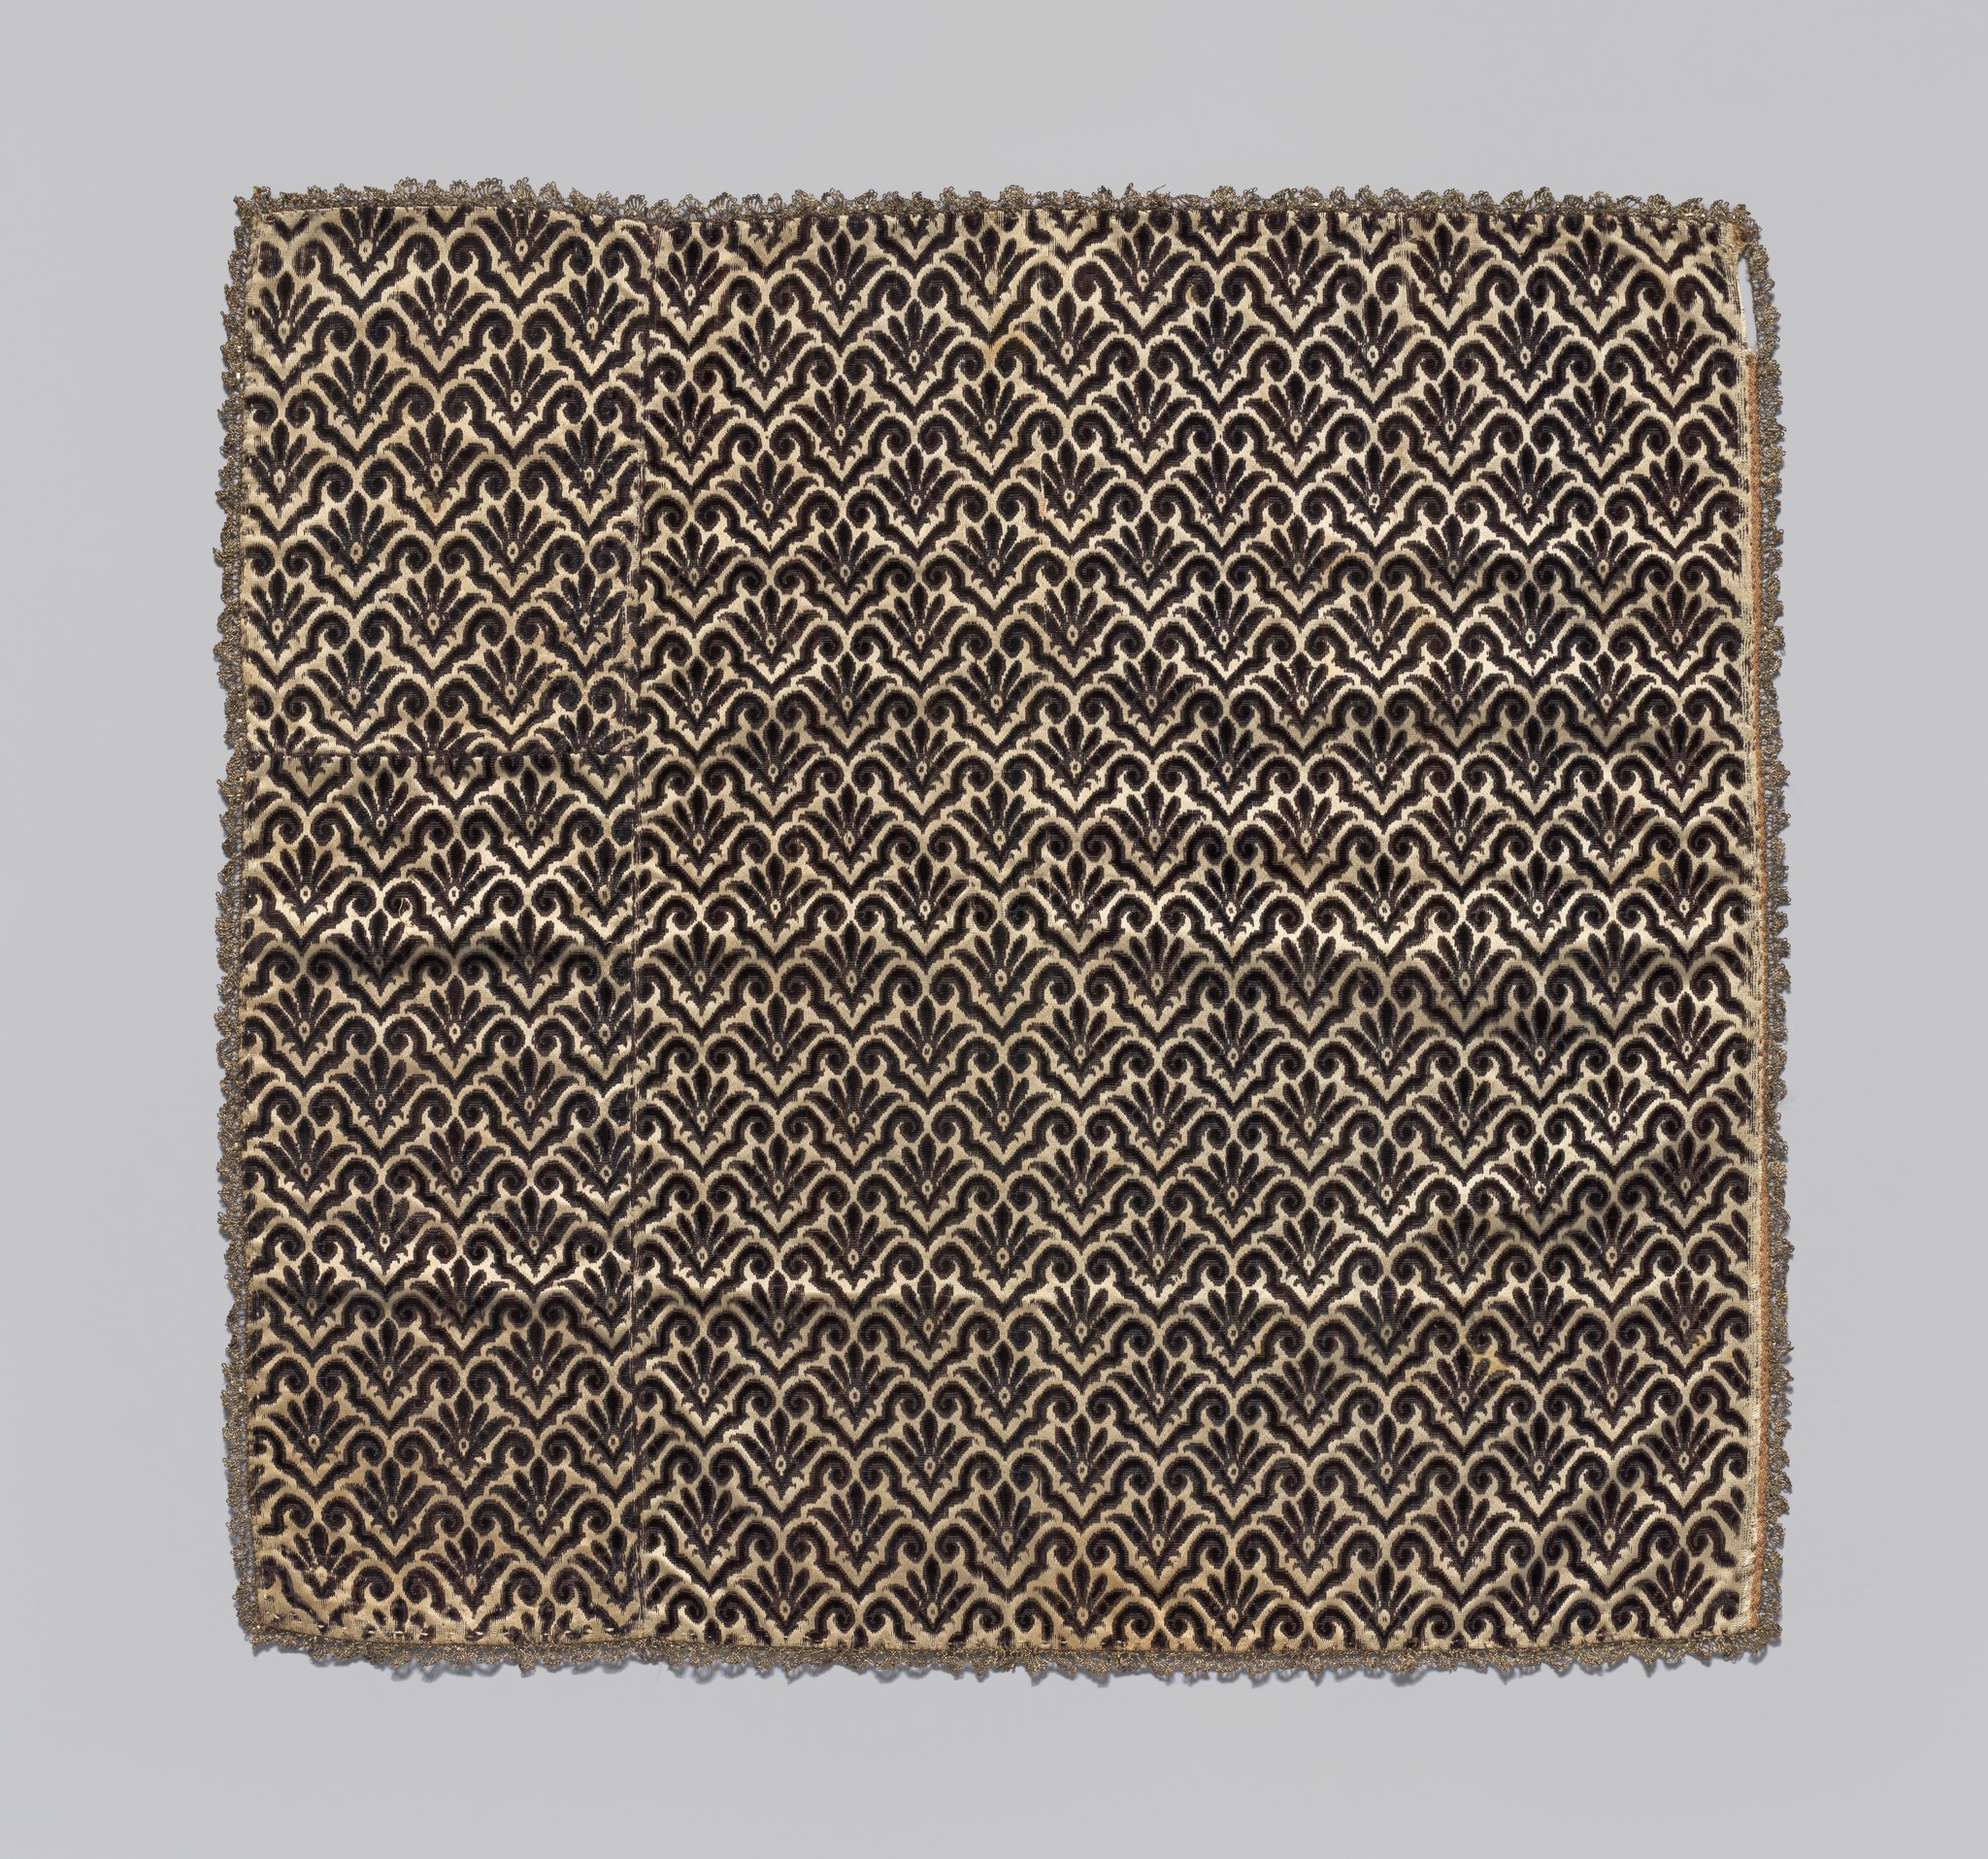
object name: piece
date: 1501-1700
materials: silk